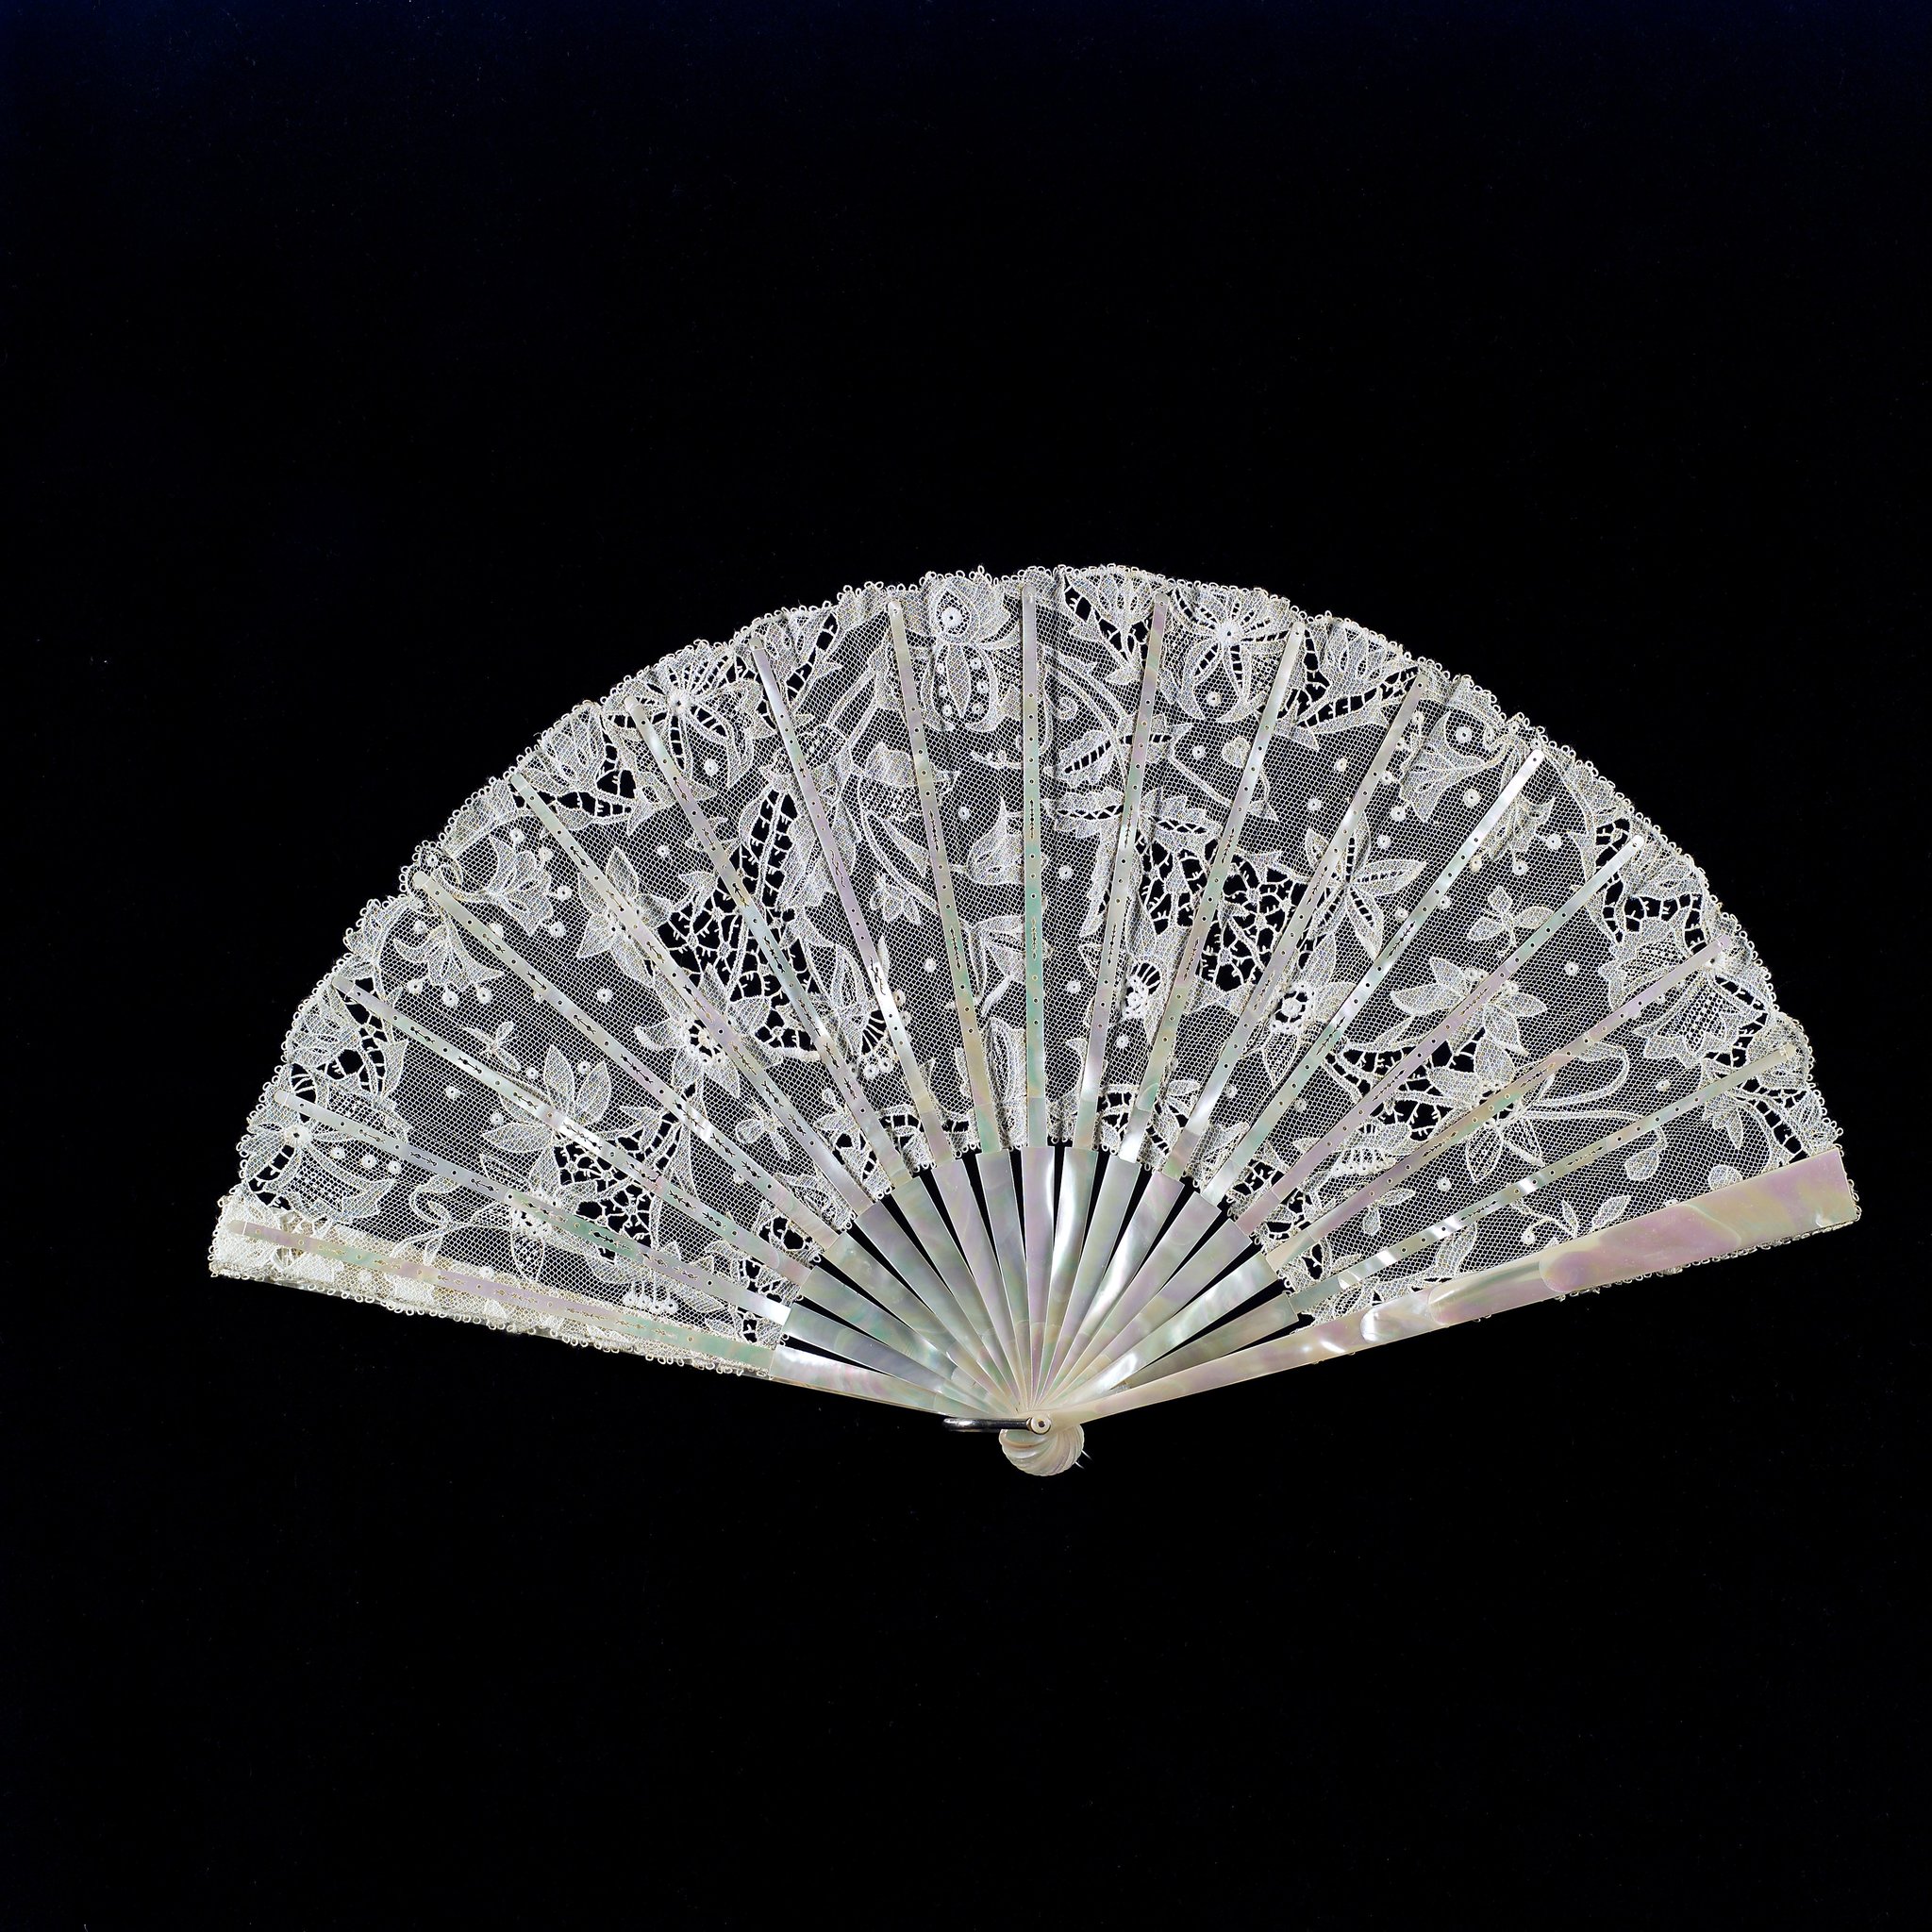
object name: fan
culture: american or european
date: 1876-1900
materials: cotton, mother of pearl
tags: flowers